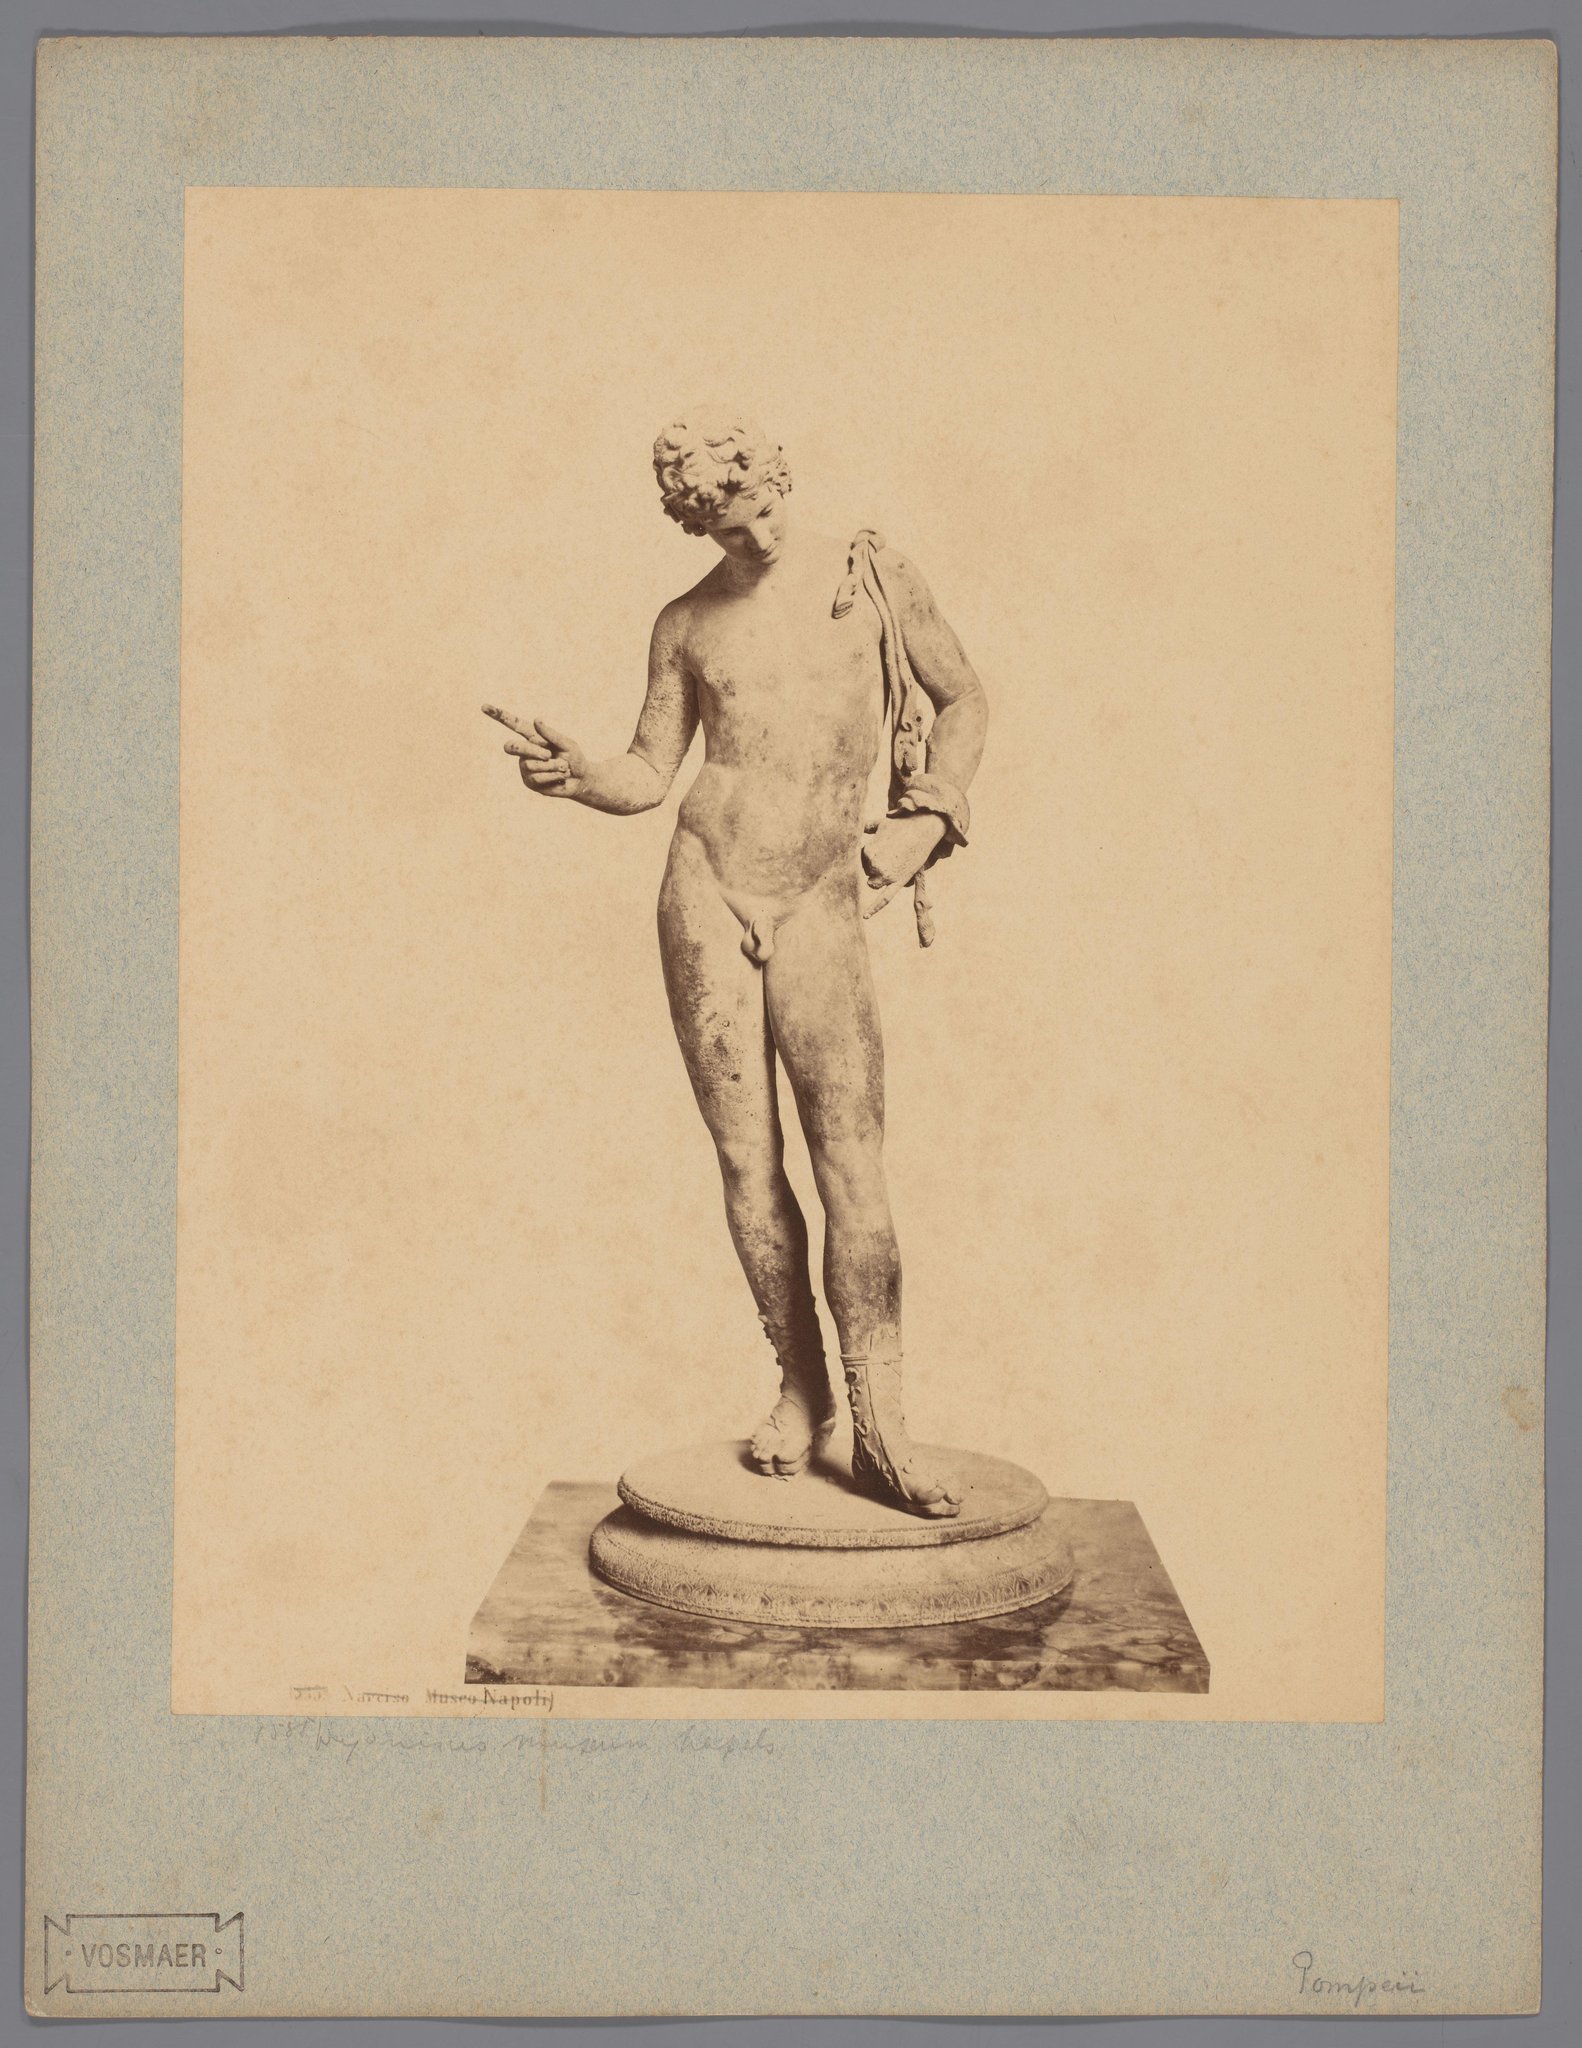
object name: photograph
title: Narciso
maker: giorgio sommer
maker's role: fotograaf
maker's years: 1834-1914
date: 1857-1914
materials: cardboard, paper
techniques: albumen print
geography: naples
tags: (story of) narcissus, piece of sculpture, reproduction of a piece of sculpture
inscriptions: inscription: ‘1585 Dyonisus Museo Napels’, collector's mark: ‘VOSMAER’, number: ‘1535 [?]’